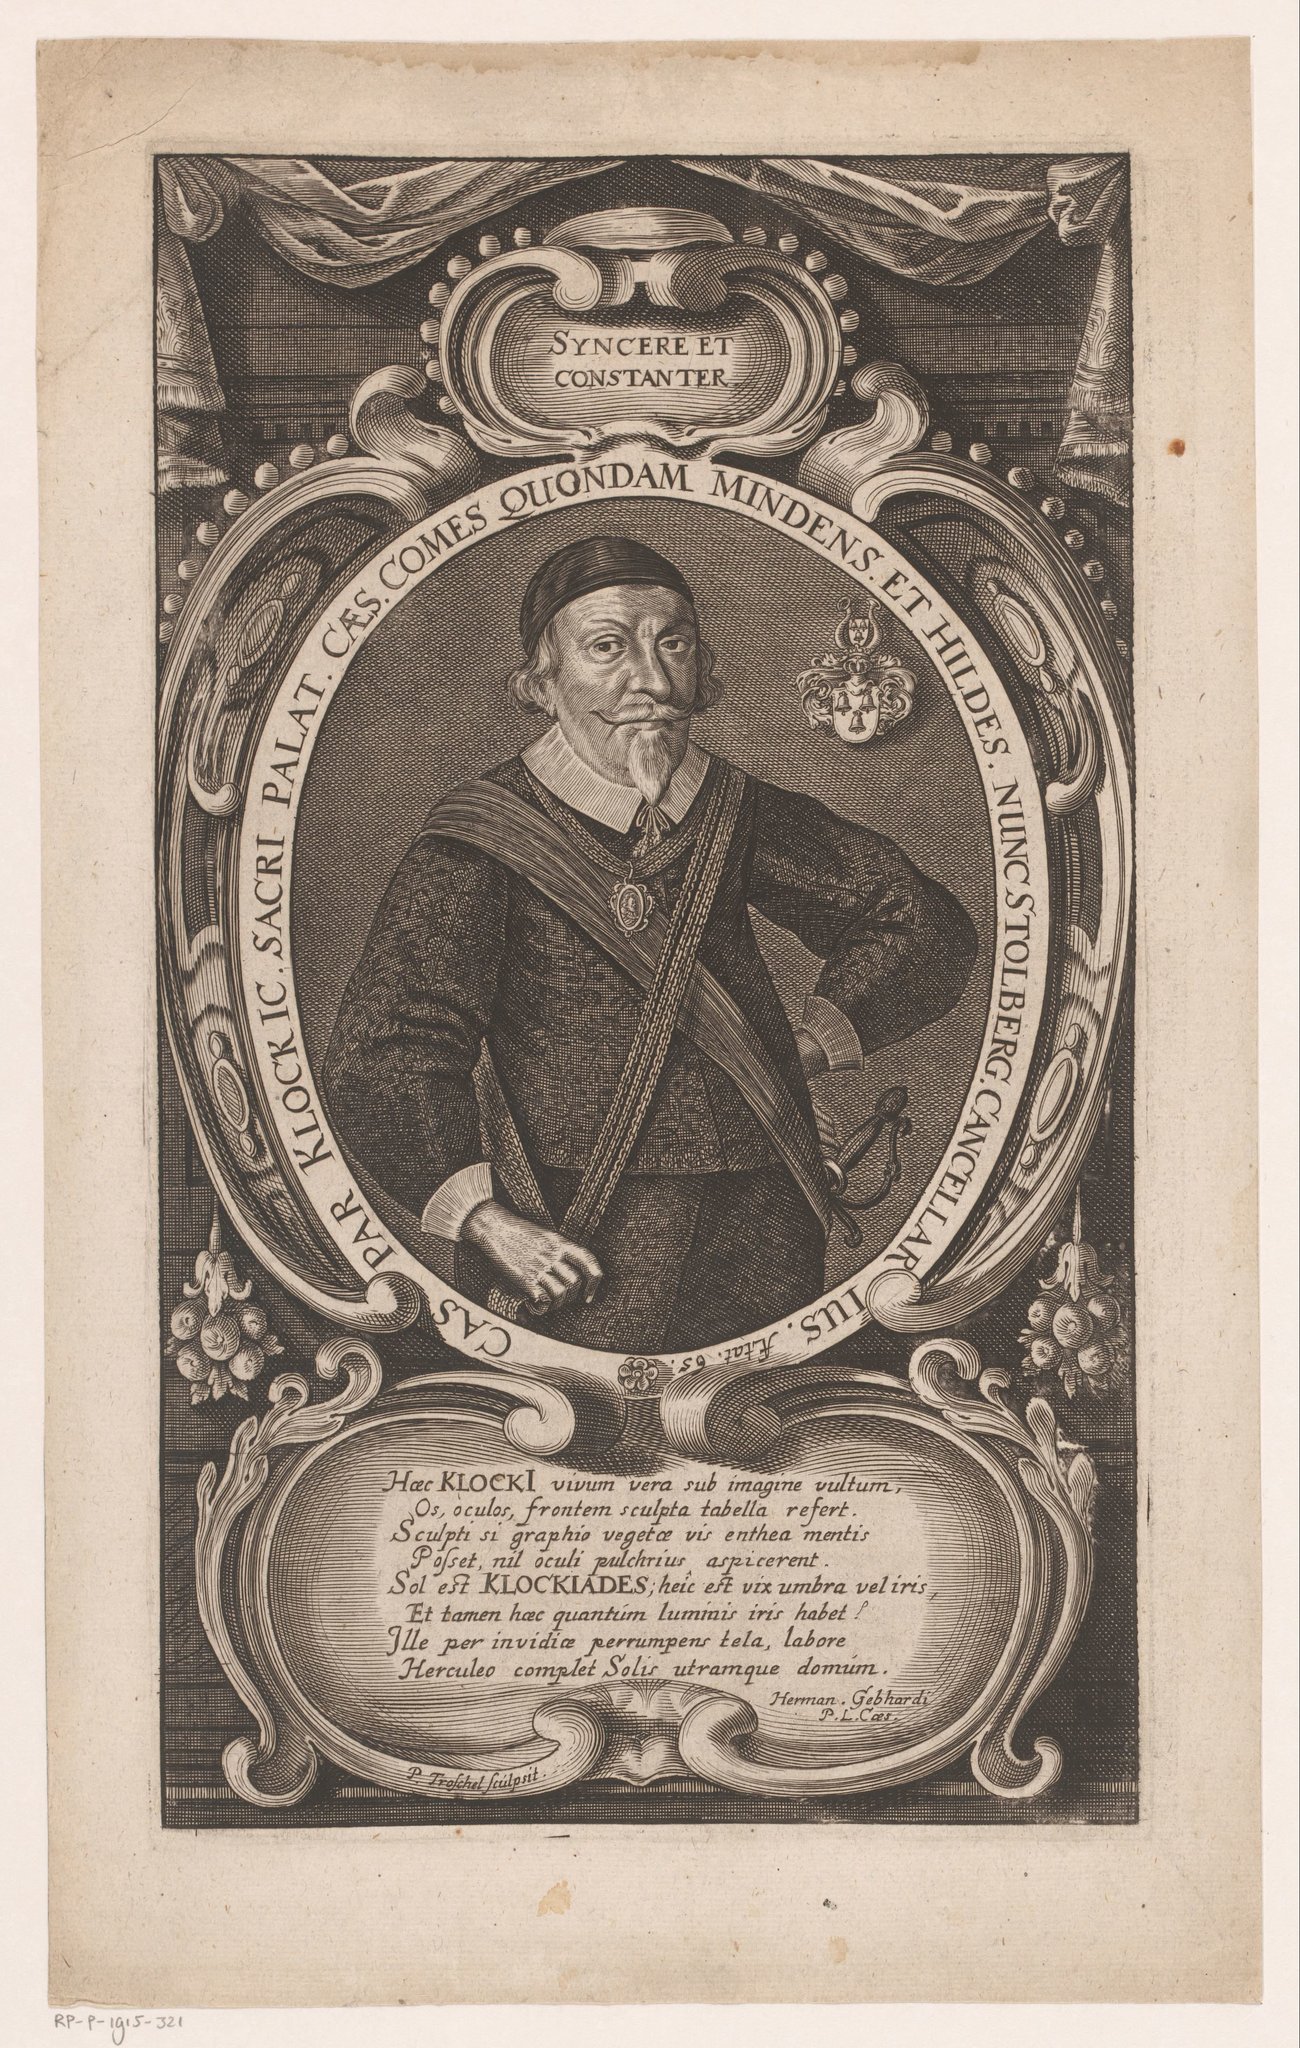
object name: print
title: Portret van Caspar Klock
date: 1648-1670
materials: paper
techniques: engraving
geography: germany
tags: historical persons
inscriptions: collector's mark: Lugt 2228